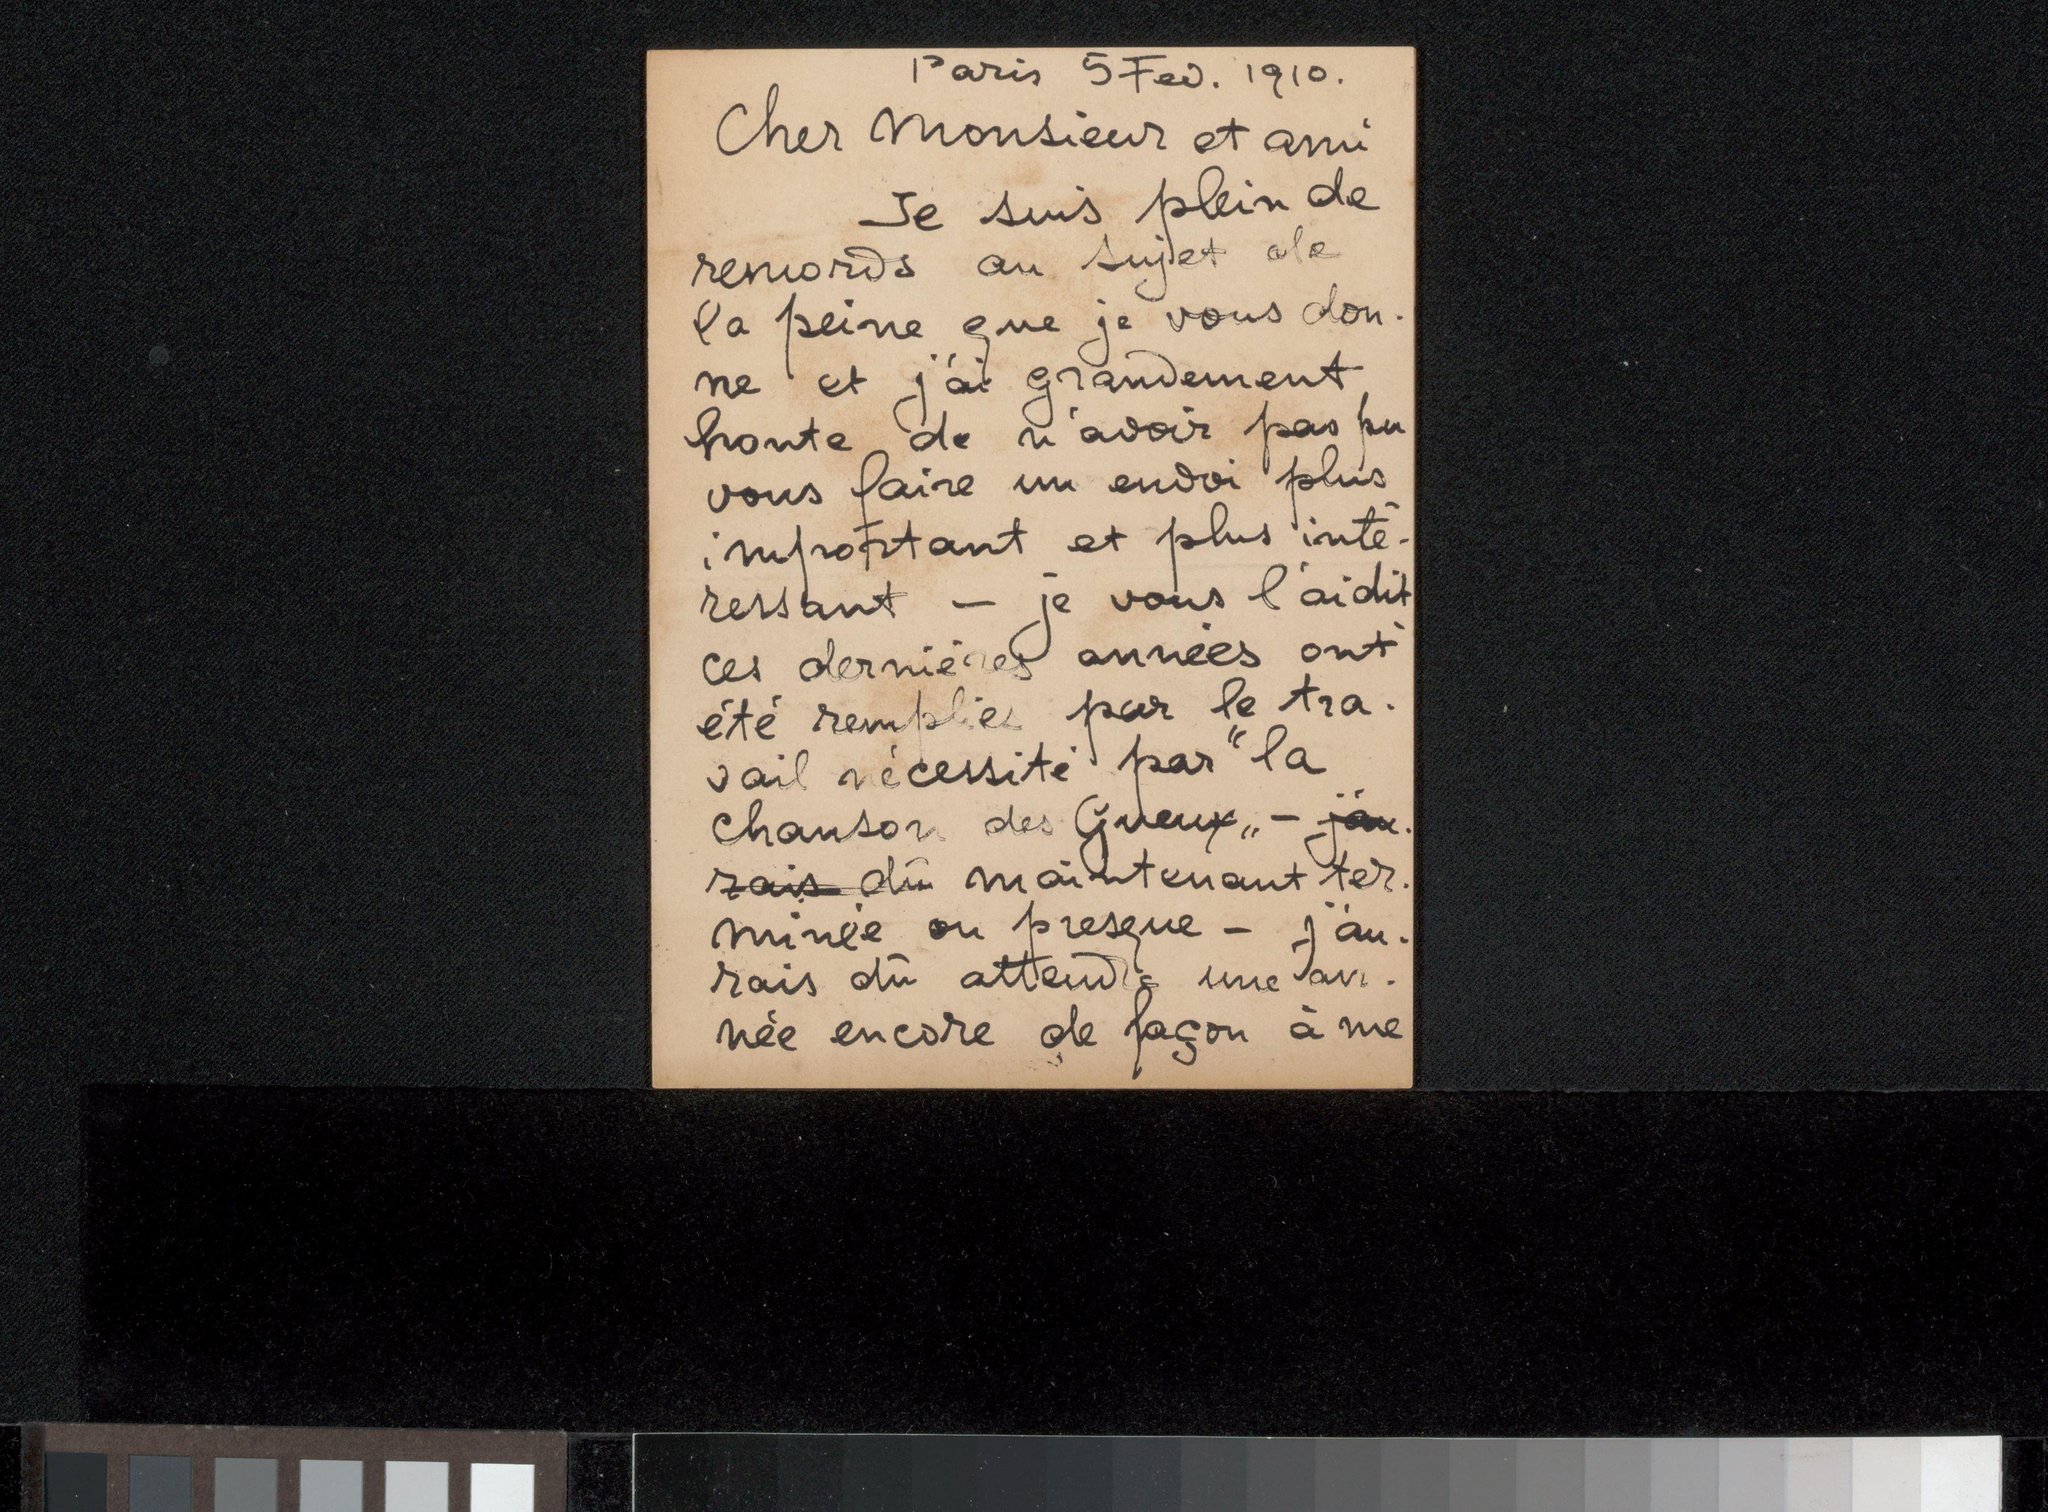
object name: letter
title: Brief aan Philip Zilcken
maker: théophile alexandre steinlen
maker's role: draughtsman, painter, print maker, sculptor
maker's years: 1859-1923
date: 1910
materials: ink, paper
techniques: pen, writing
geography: paris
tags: painter, draughtsman, philip zilcken, drawing, the graphic arts, exhibition ~ art, money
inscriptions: collector's mark: ‘RPK’